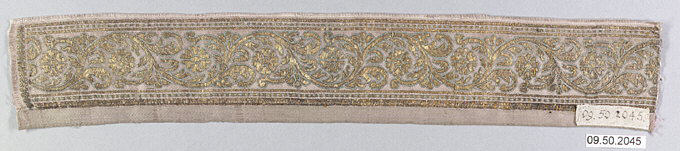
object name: strip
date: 1801-1900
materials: metal thread, silk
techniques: brocade, satin weave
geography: india